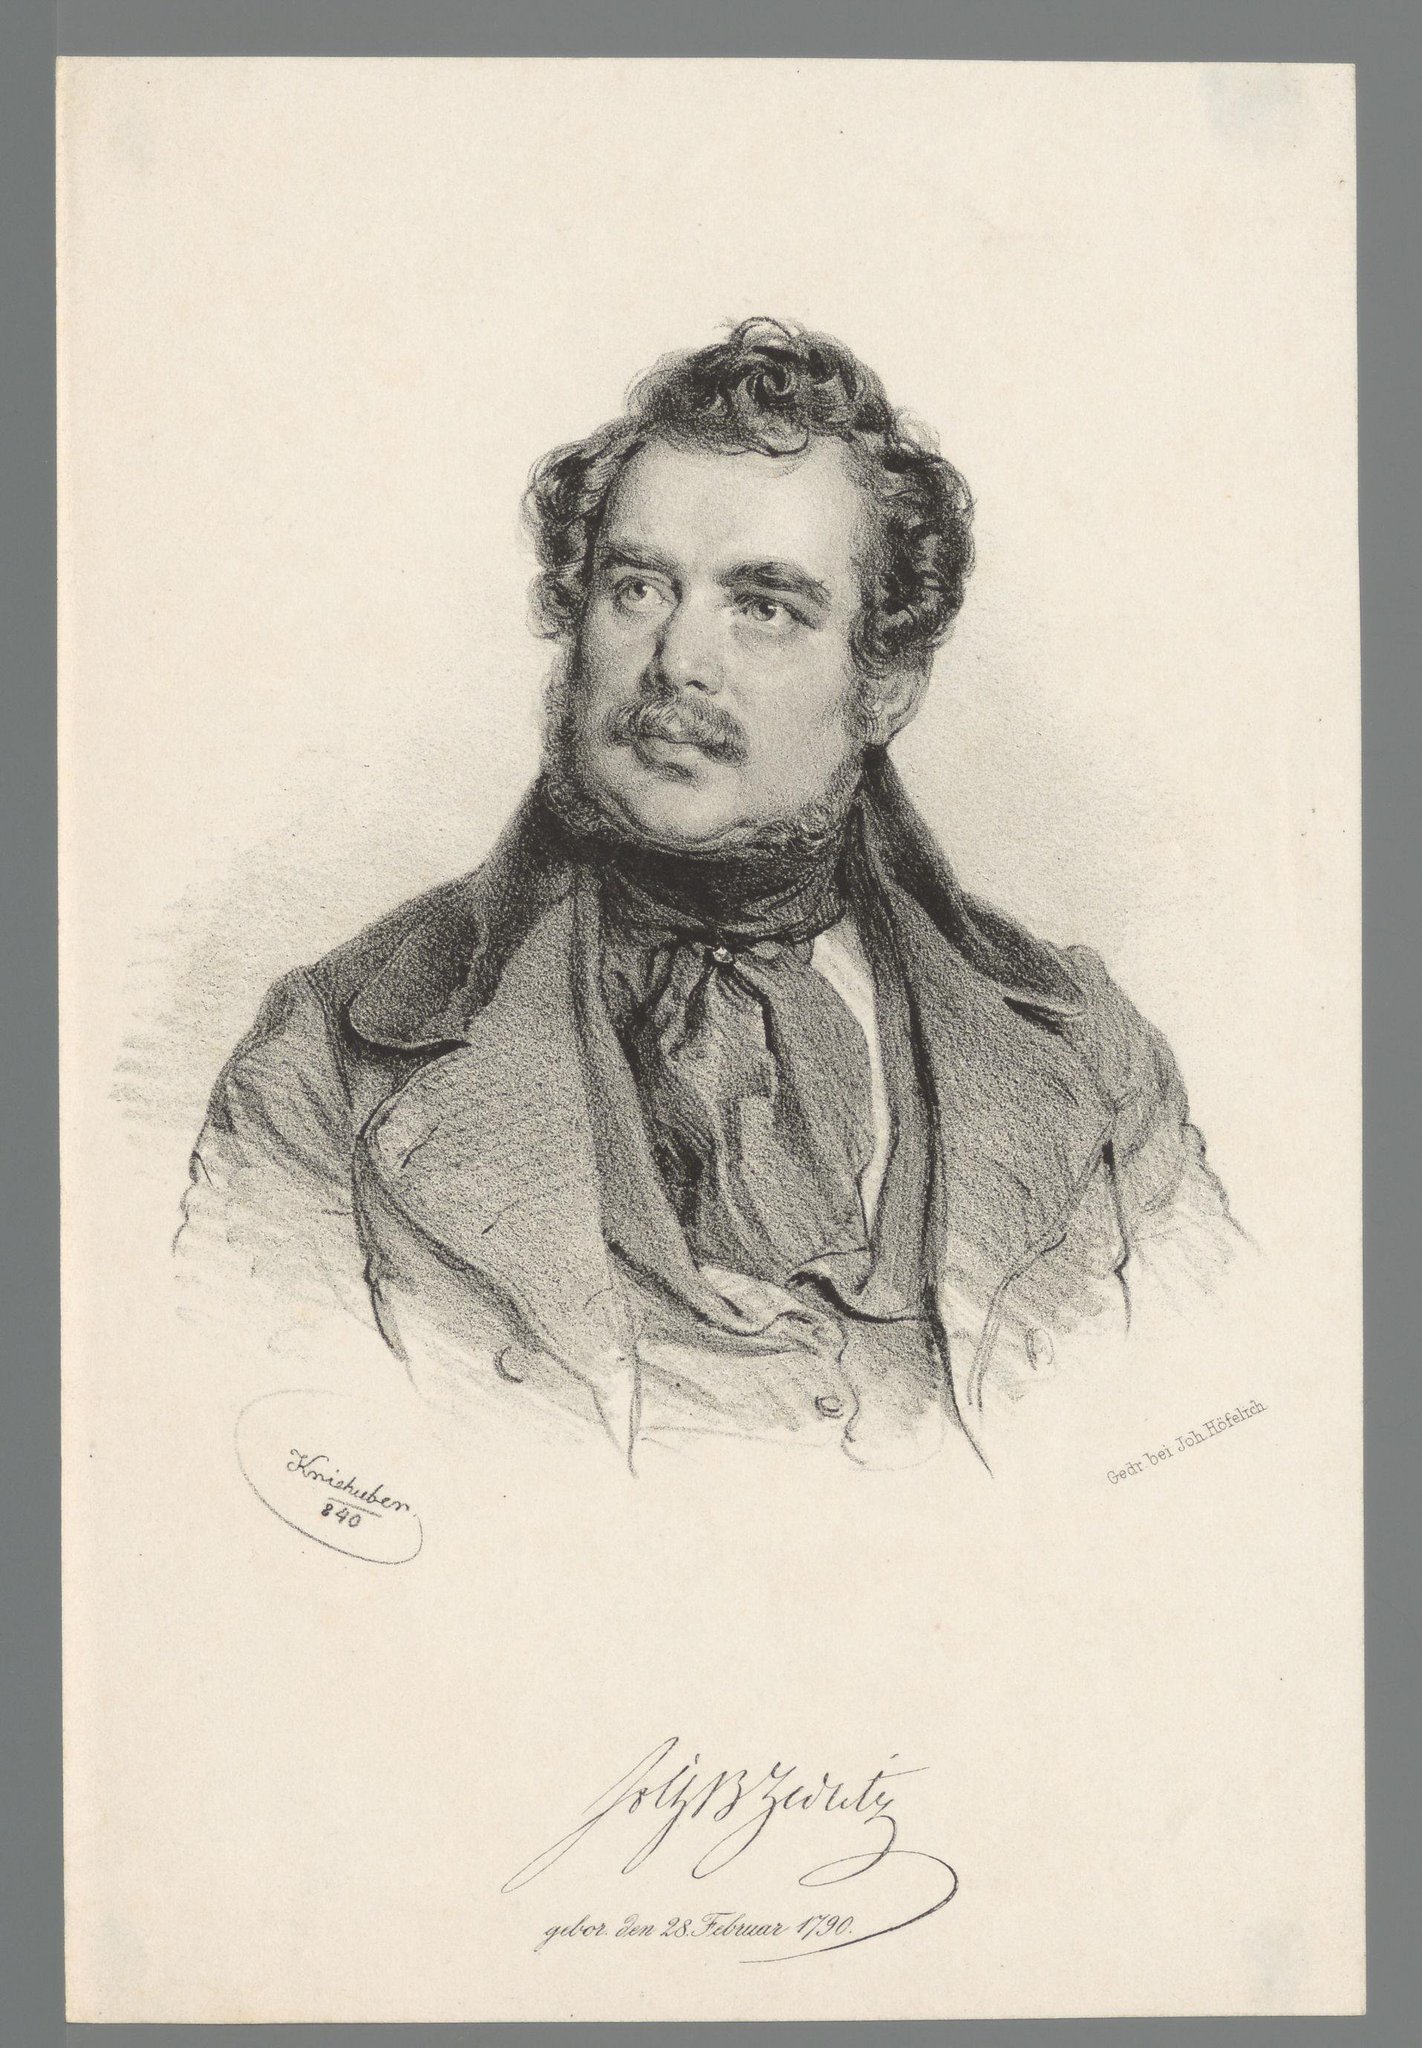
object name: print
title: Portret van Joseph Christian von Zedlitz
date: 1840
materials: paper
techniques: lithograph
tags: vienna, historical persons, portrait of a writer, officer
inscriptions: collector's mark: Lugt 2228